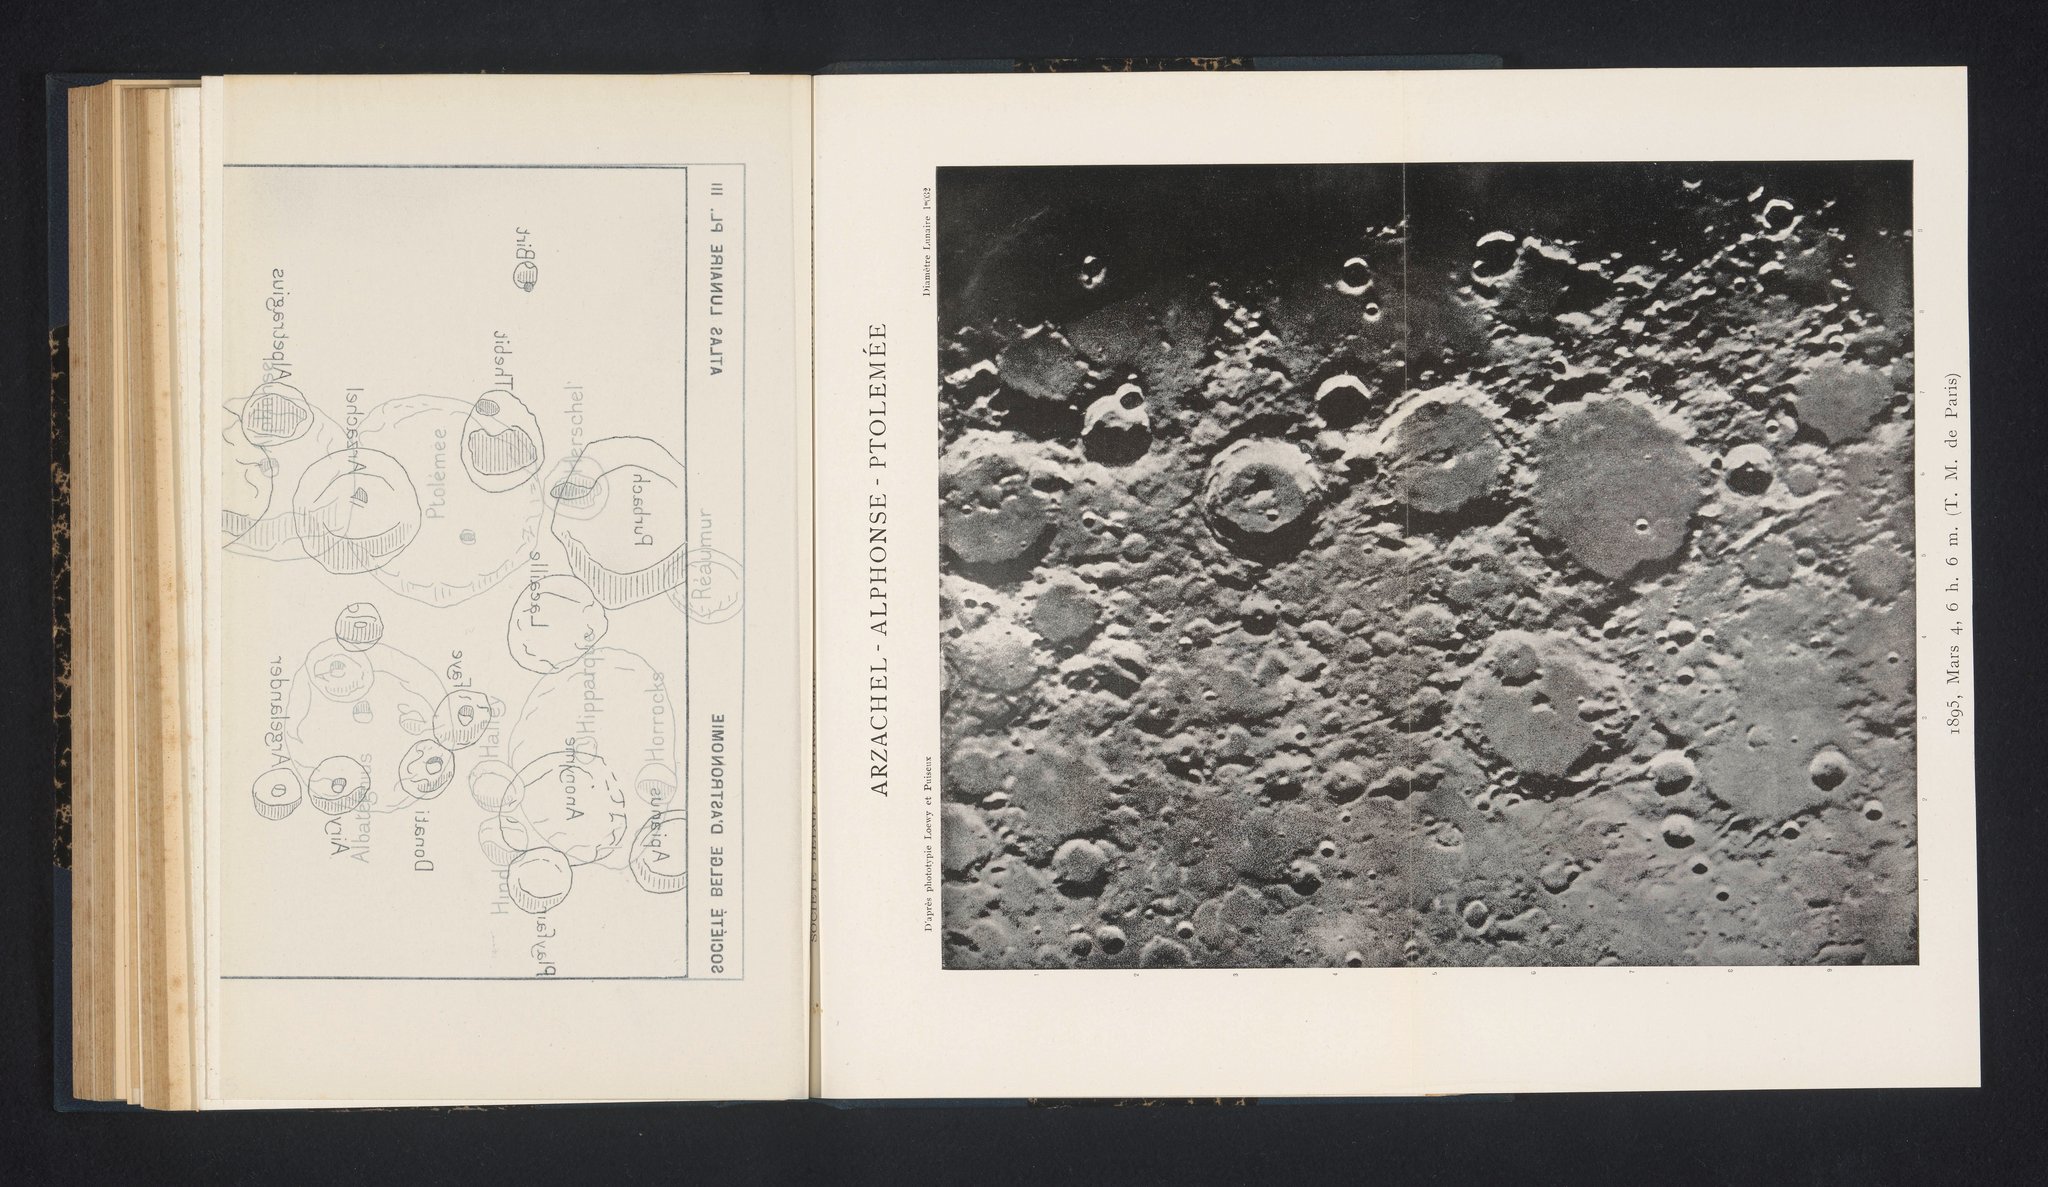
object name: photomechanical print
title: Kraters op de maan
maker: loewy et puiseux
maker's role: fotograaf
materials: paper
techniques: autotype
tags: surface of the moon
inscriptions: inscription: ‘Société Belge d'Astronomie Atlas Lunaire Pl III/ 1895, Mars 04. 6h, 6m. (T. M. de Paris)’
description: Transparante pagina voor prent als kaart met daarop de namen van de verschillende kraters.